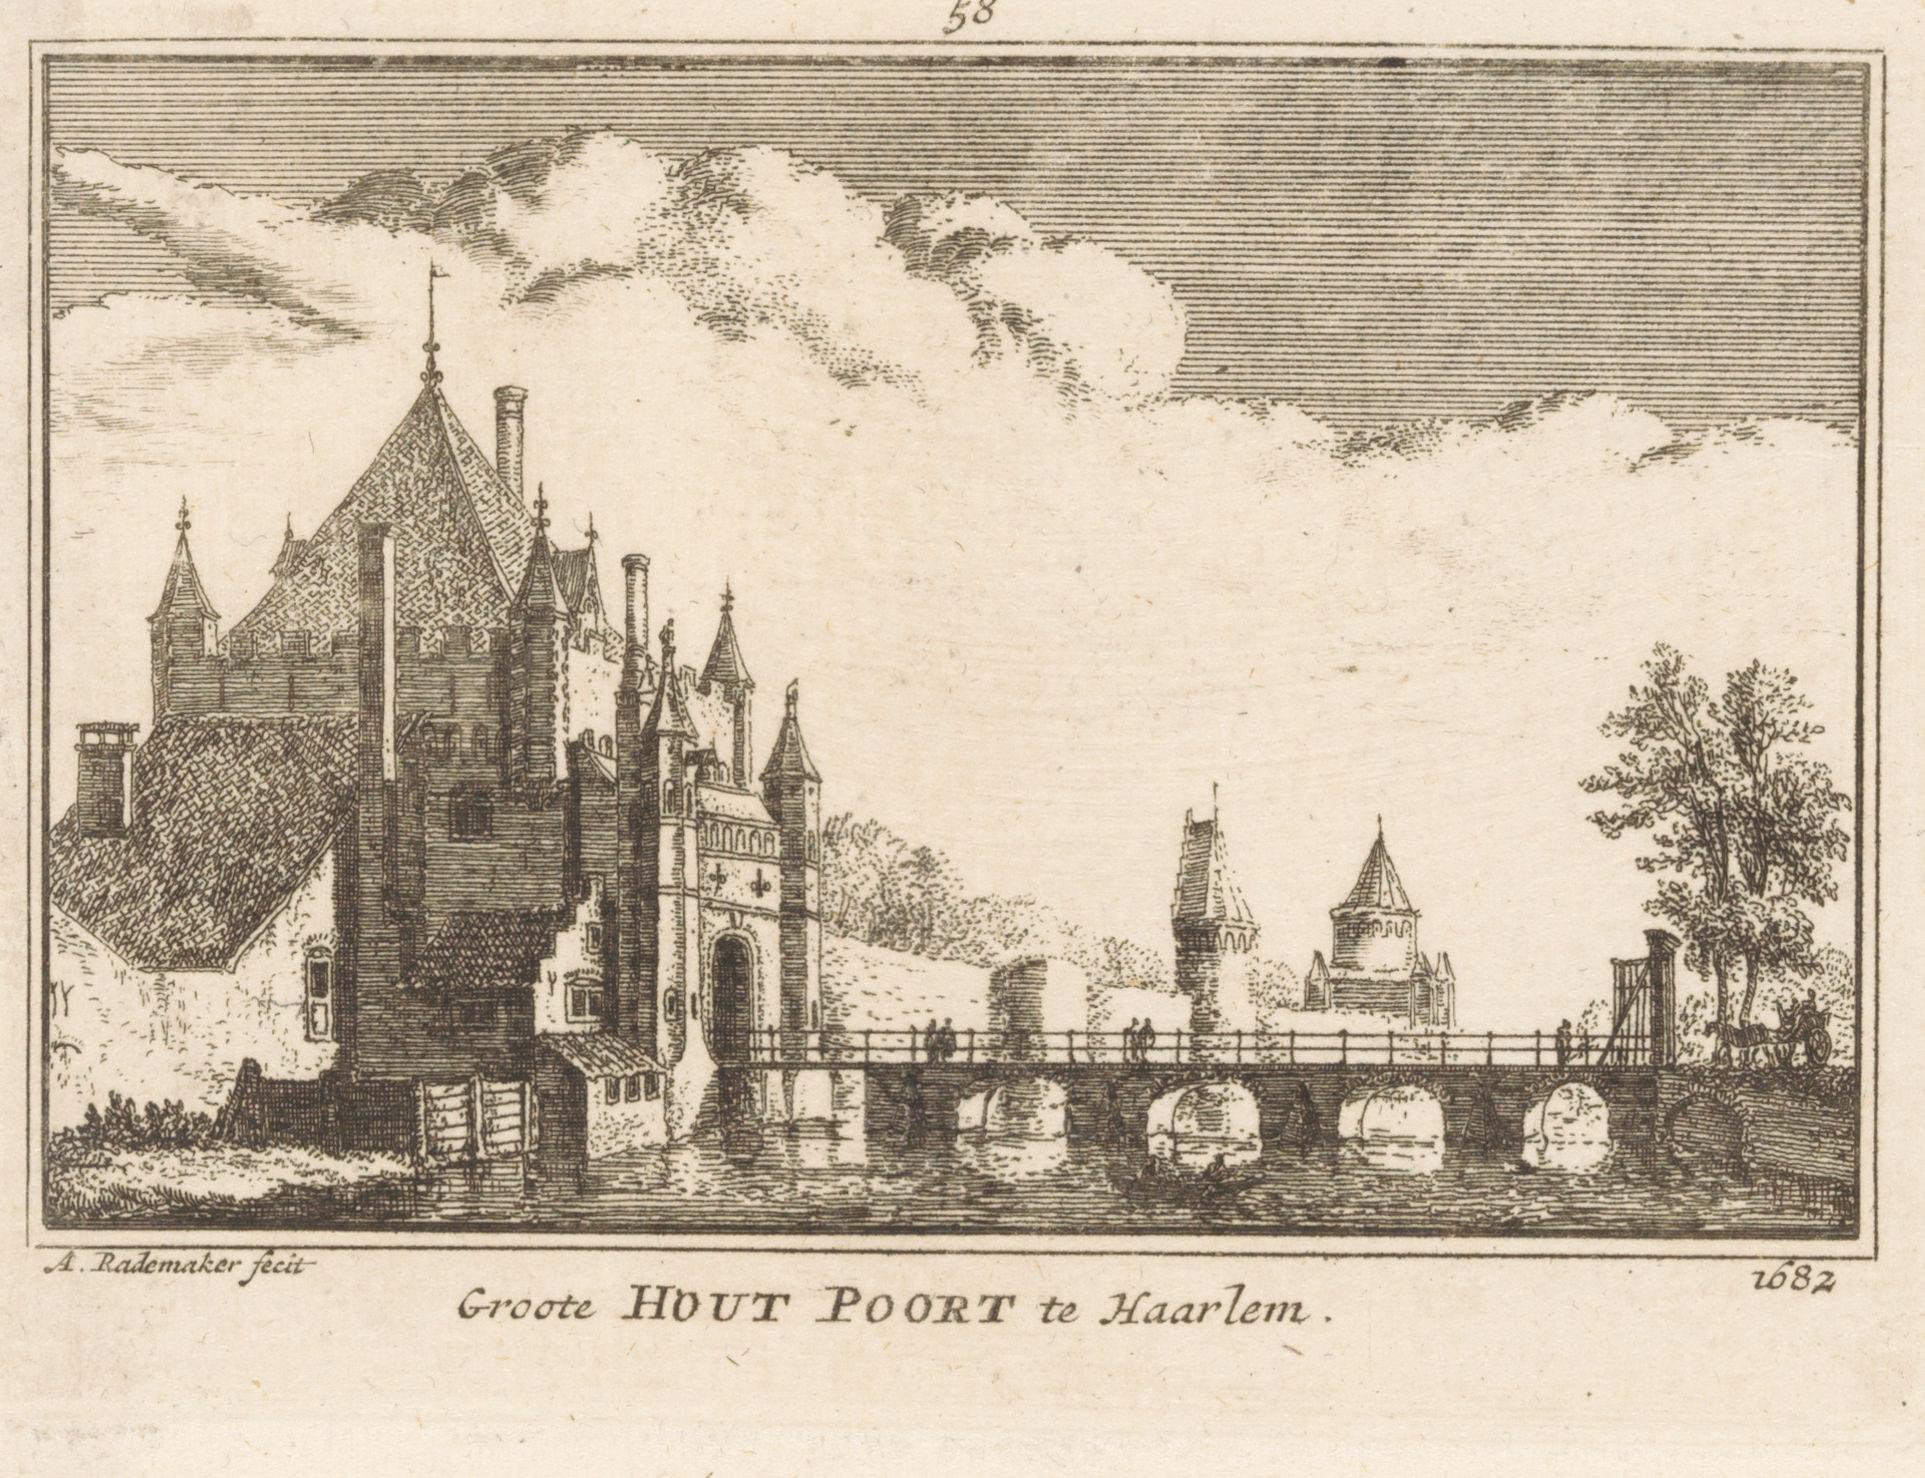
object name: book illustration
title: Groote Hout Poort te Haarlem. 1682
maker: abraham rademaker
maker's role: draughtsman, print maker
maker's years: 1676-1735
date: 1725-1803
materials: paper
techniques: engraving, etching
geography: amsterdam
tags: bridge, city-gate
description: Prent ook gebruikt in: Rademaker, Abraham. Kabinet van Nederlandsche outheden en gezichten: vervat in 300 konstplaaten (…). 2 delen. Amsterdam: Willem Barents, 1725, dl. 1, ill. 58. Na 1725 is deze prent nog in verschillende heruitgaven verschenen, uitgegeven in 1727-1733, 1770-1771 en 1792-1803. Uit welke uitgave het huidige exemplaar precies komt is niet na te gaan.